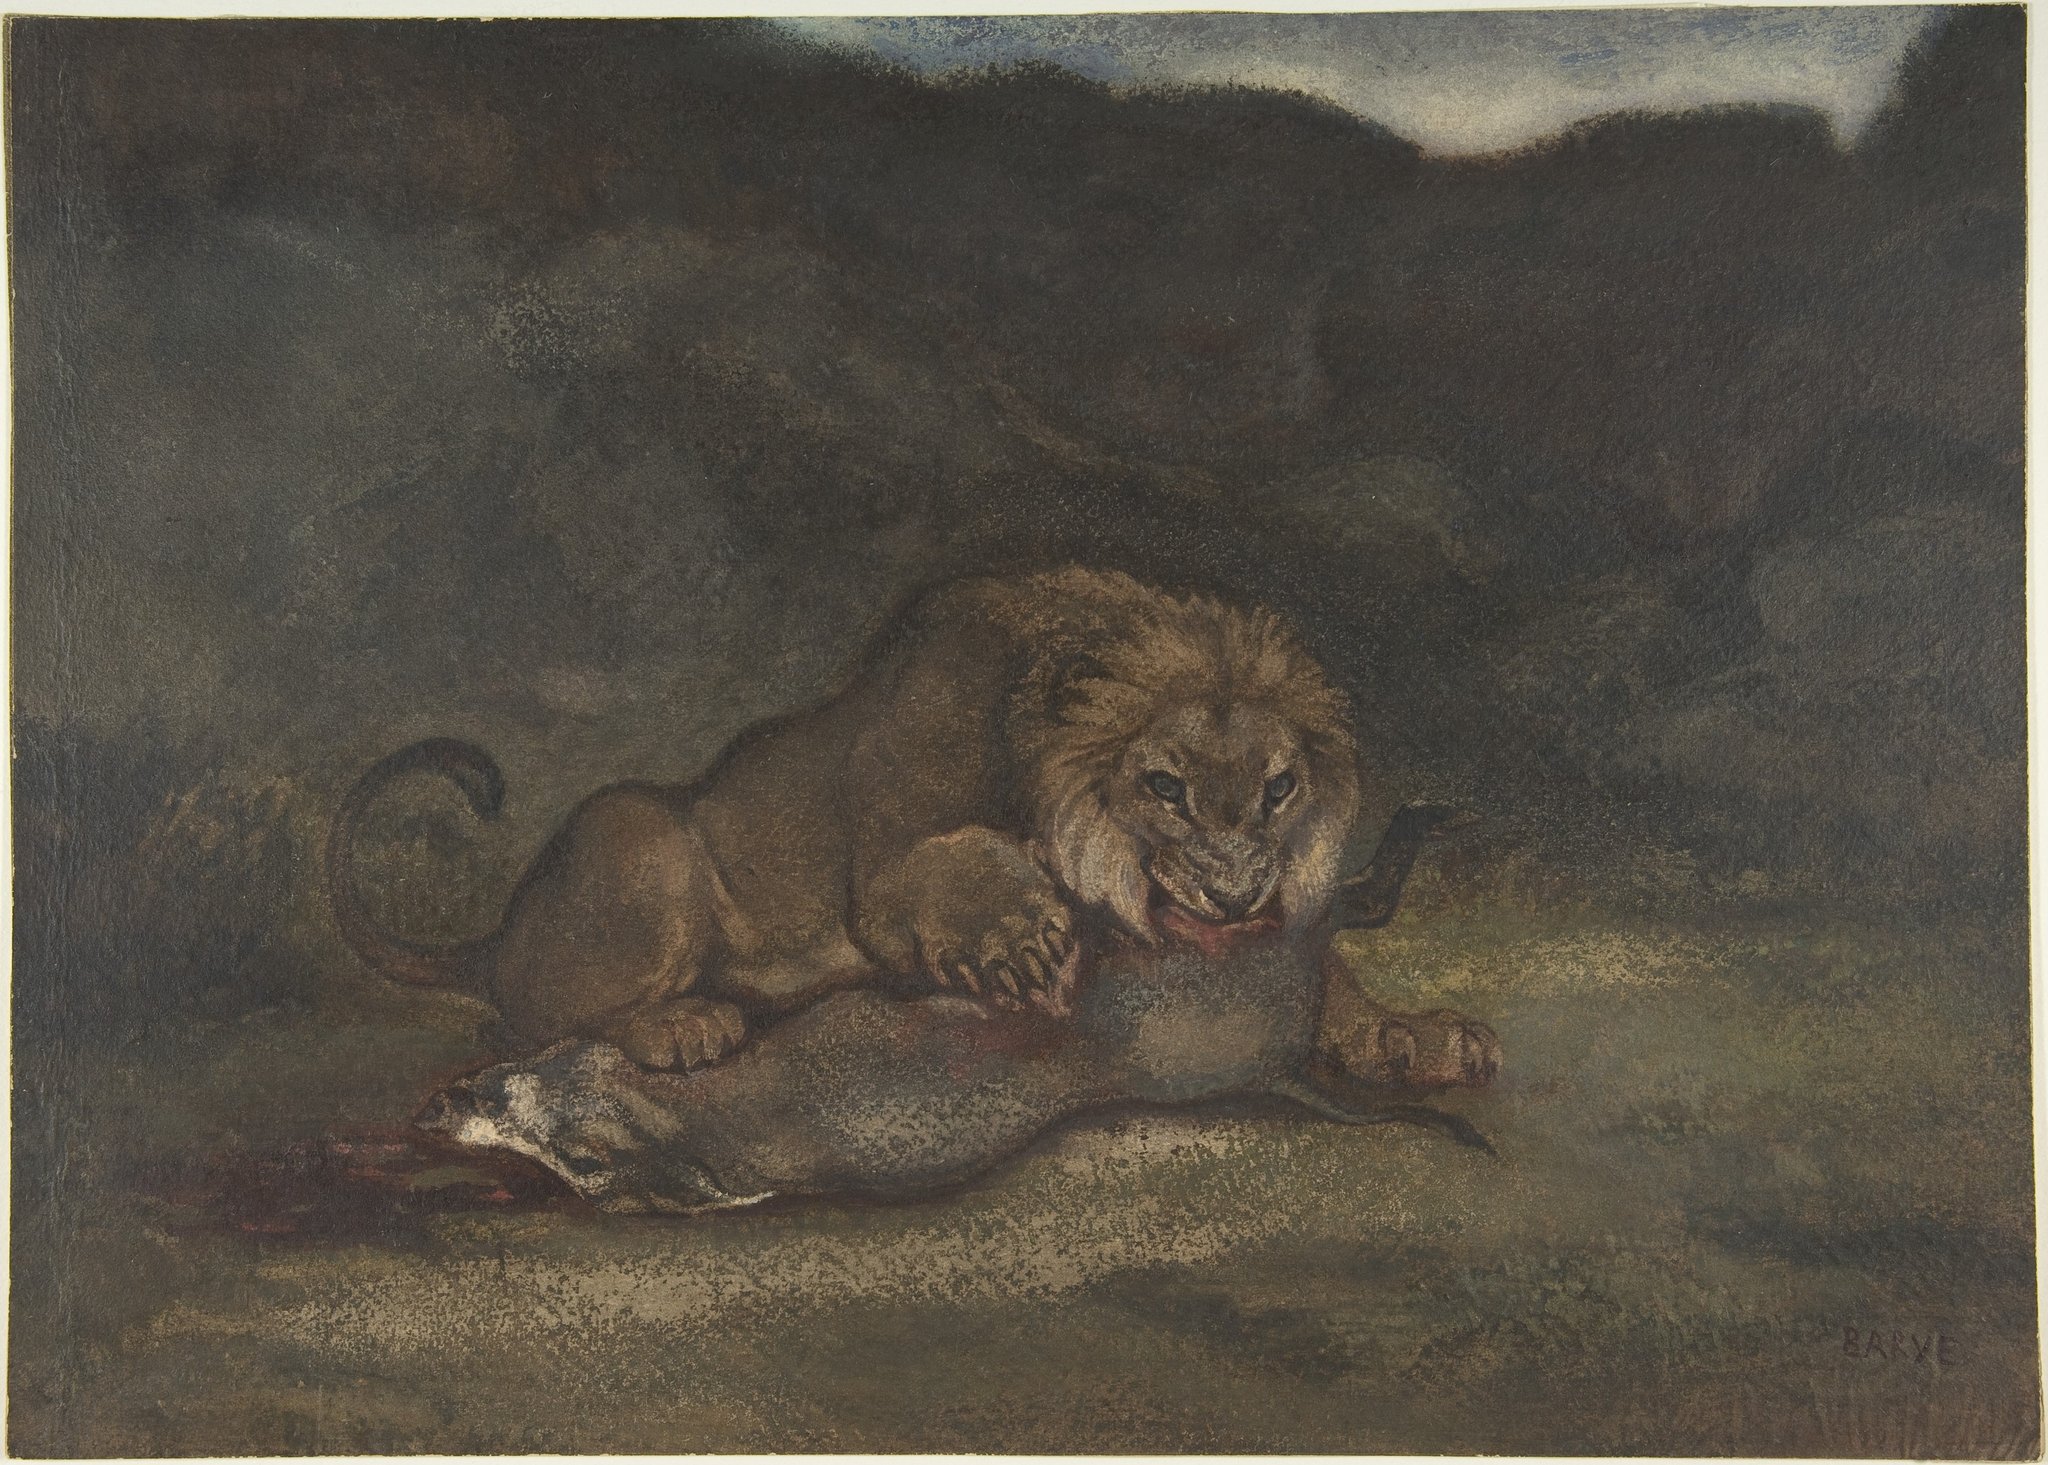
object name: drawing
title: Lion Devouring Prey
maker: antoine-louis barye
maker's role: artist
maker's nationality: french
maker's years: 1795-1875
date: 1810-1875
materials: watercolor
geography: france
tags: lions